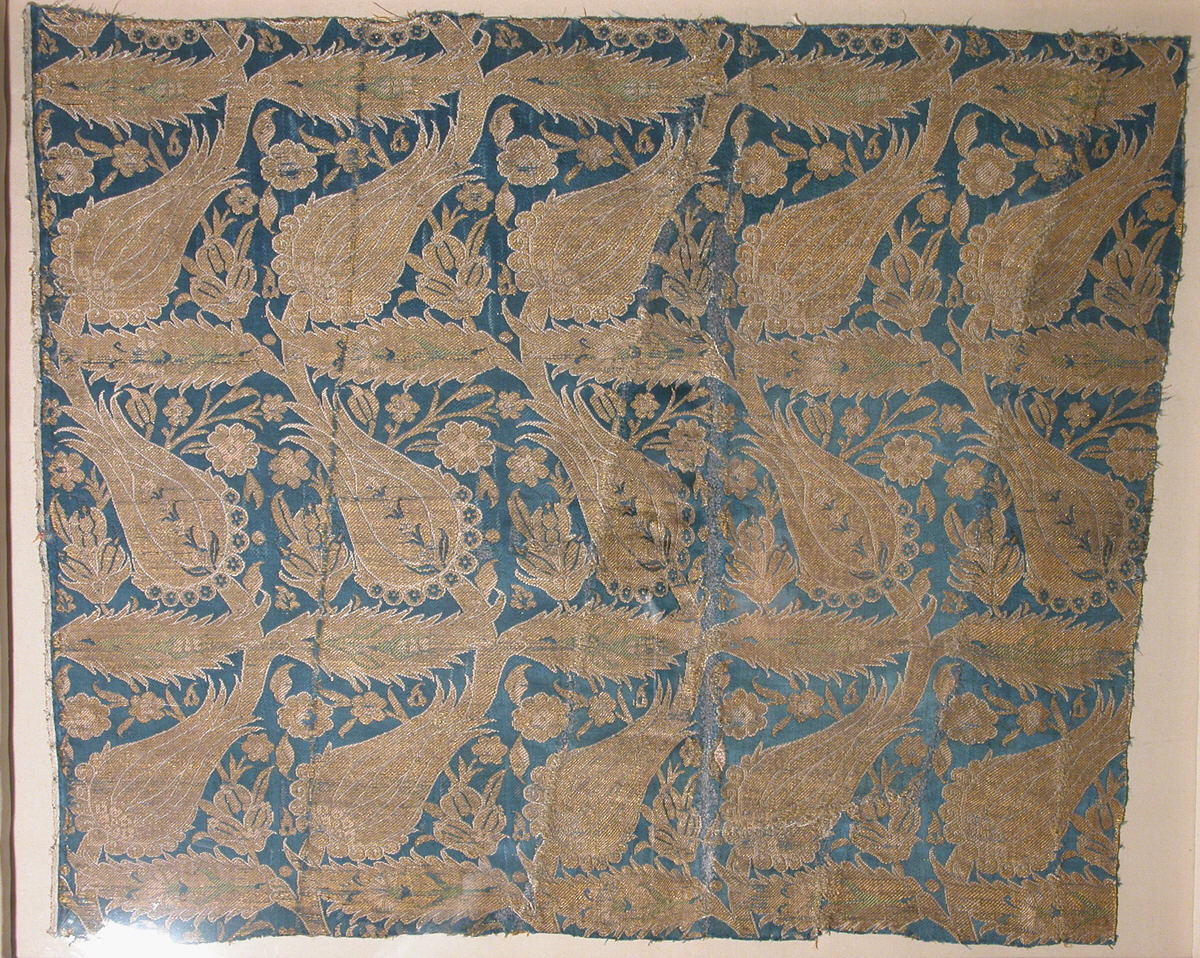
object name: textile fragment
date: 1601-1700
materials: metal thread, silk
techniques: lampas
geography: turkey